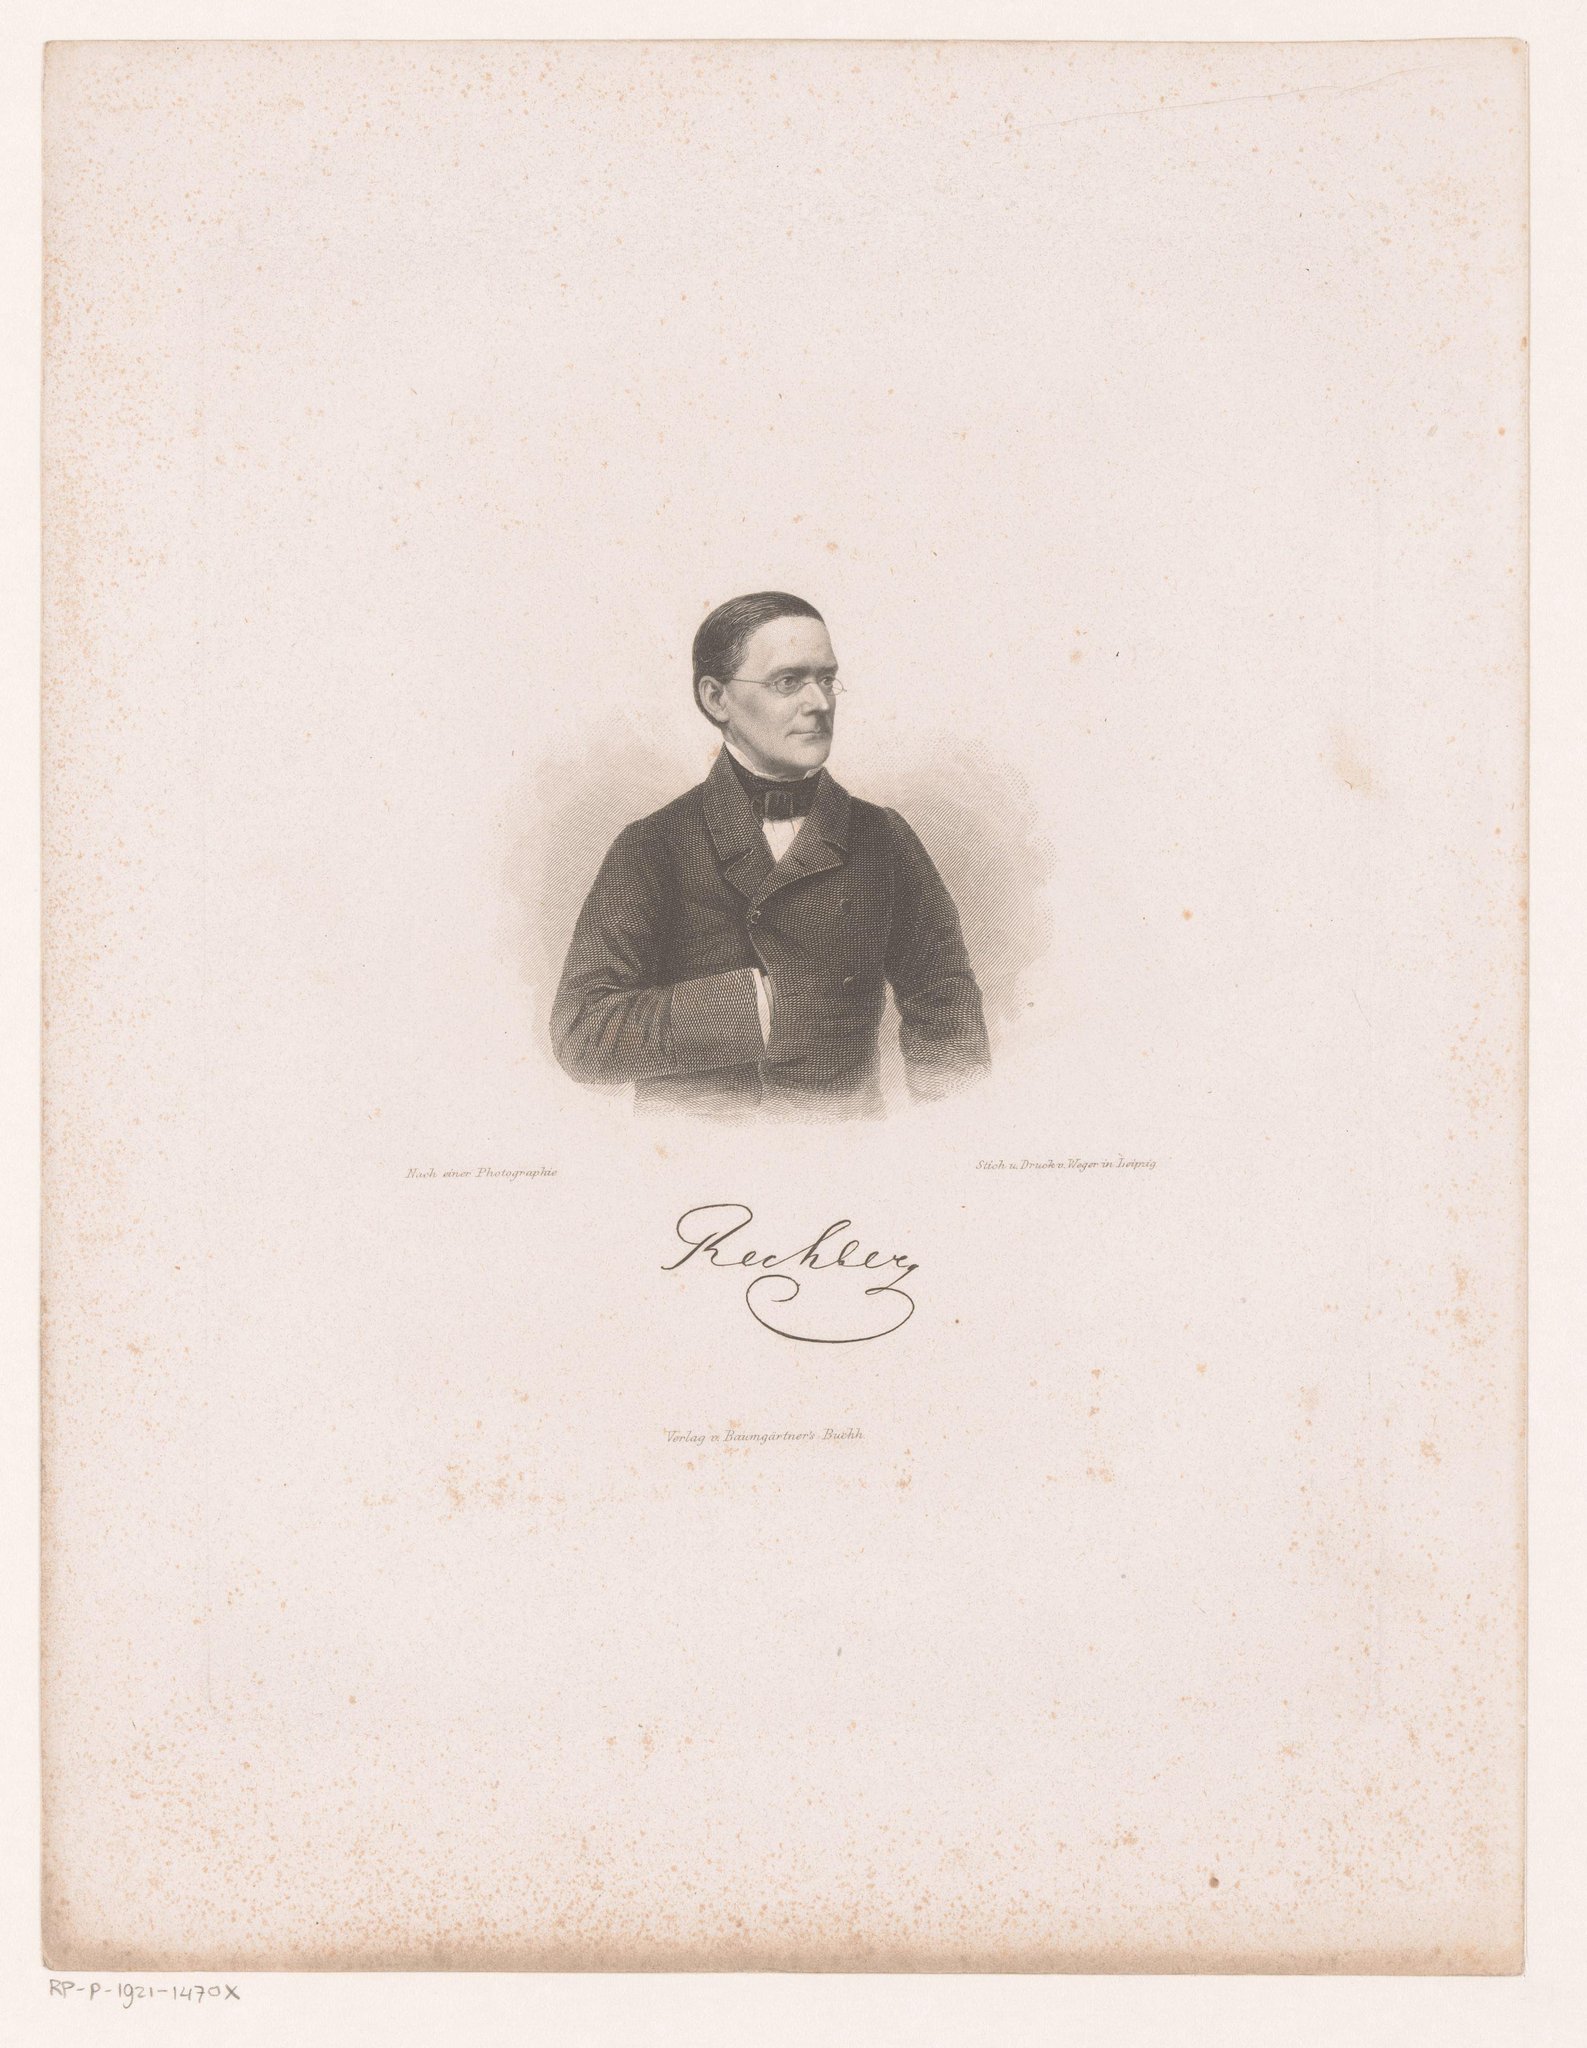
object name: print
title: Portret van Bernhard von Rechberg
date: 1849-1892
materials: paper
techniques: engraving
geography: leipzig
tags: historical persons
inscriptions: collector's mark: Lugt 2233